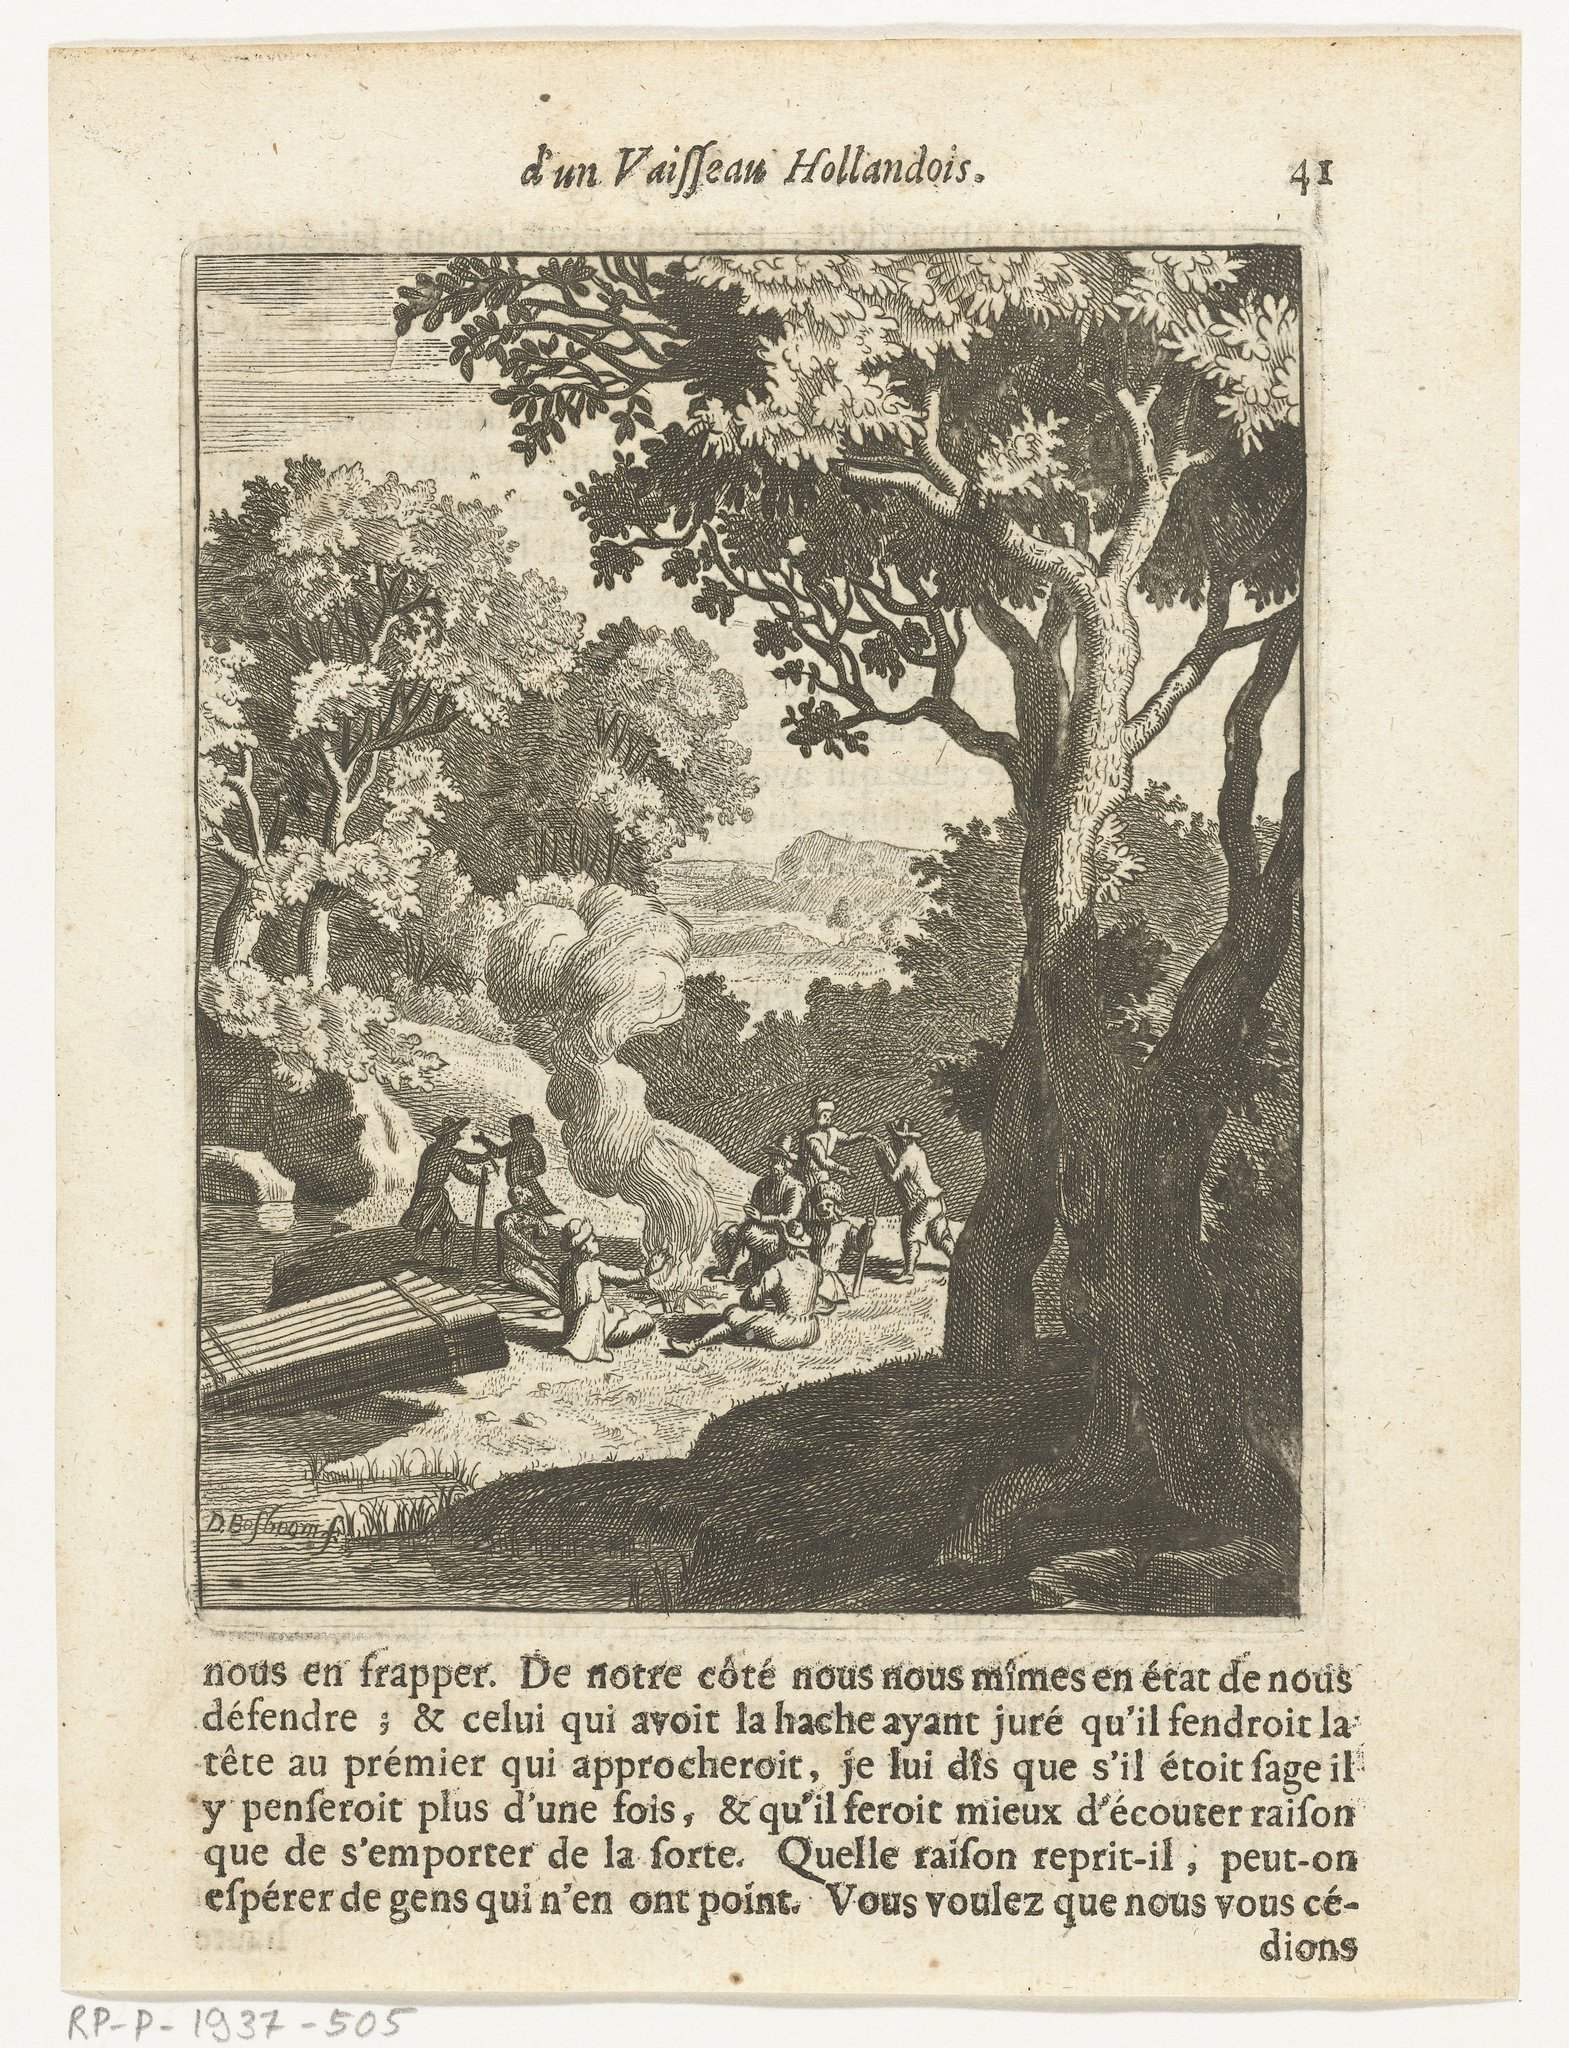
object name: book illustration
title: Mannen bij een kampvuur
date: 1681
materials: paper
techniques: engraving, etching, letterpress printing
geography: amsterdam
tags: camp-fire; watch-fire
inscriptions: collector's mark: Lugt 2228, collector's mark: Lugt 2760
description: Een deel van de bemanning van het VOC-schip Terschelling probeert met een vlot naar het vaste land te komen maar keert uiteindelijk weer terug naar het eiland. Rond het kampvuur overleggen de mannen wat nu verder te doen is.